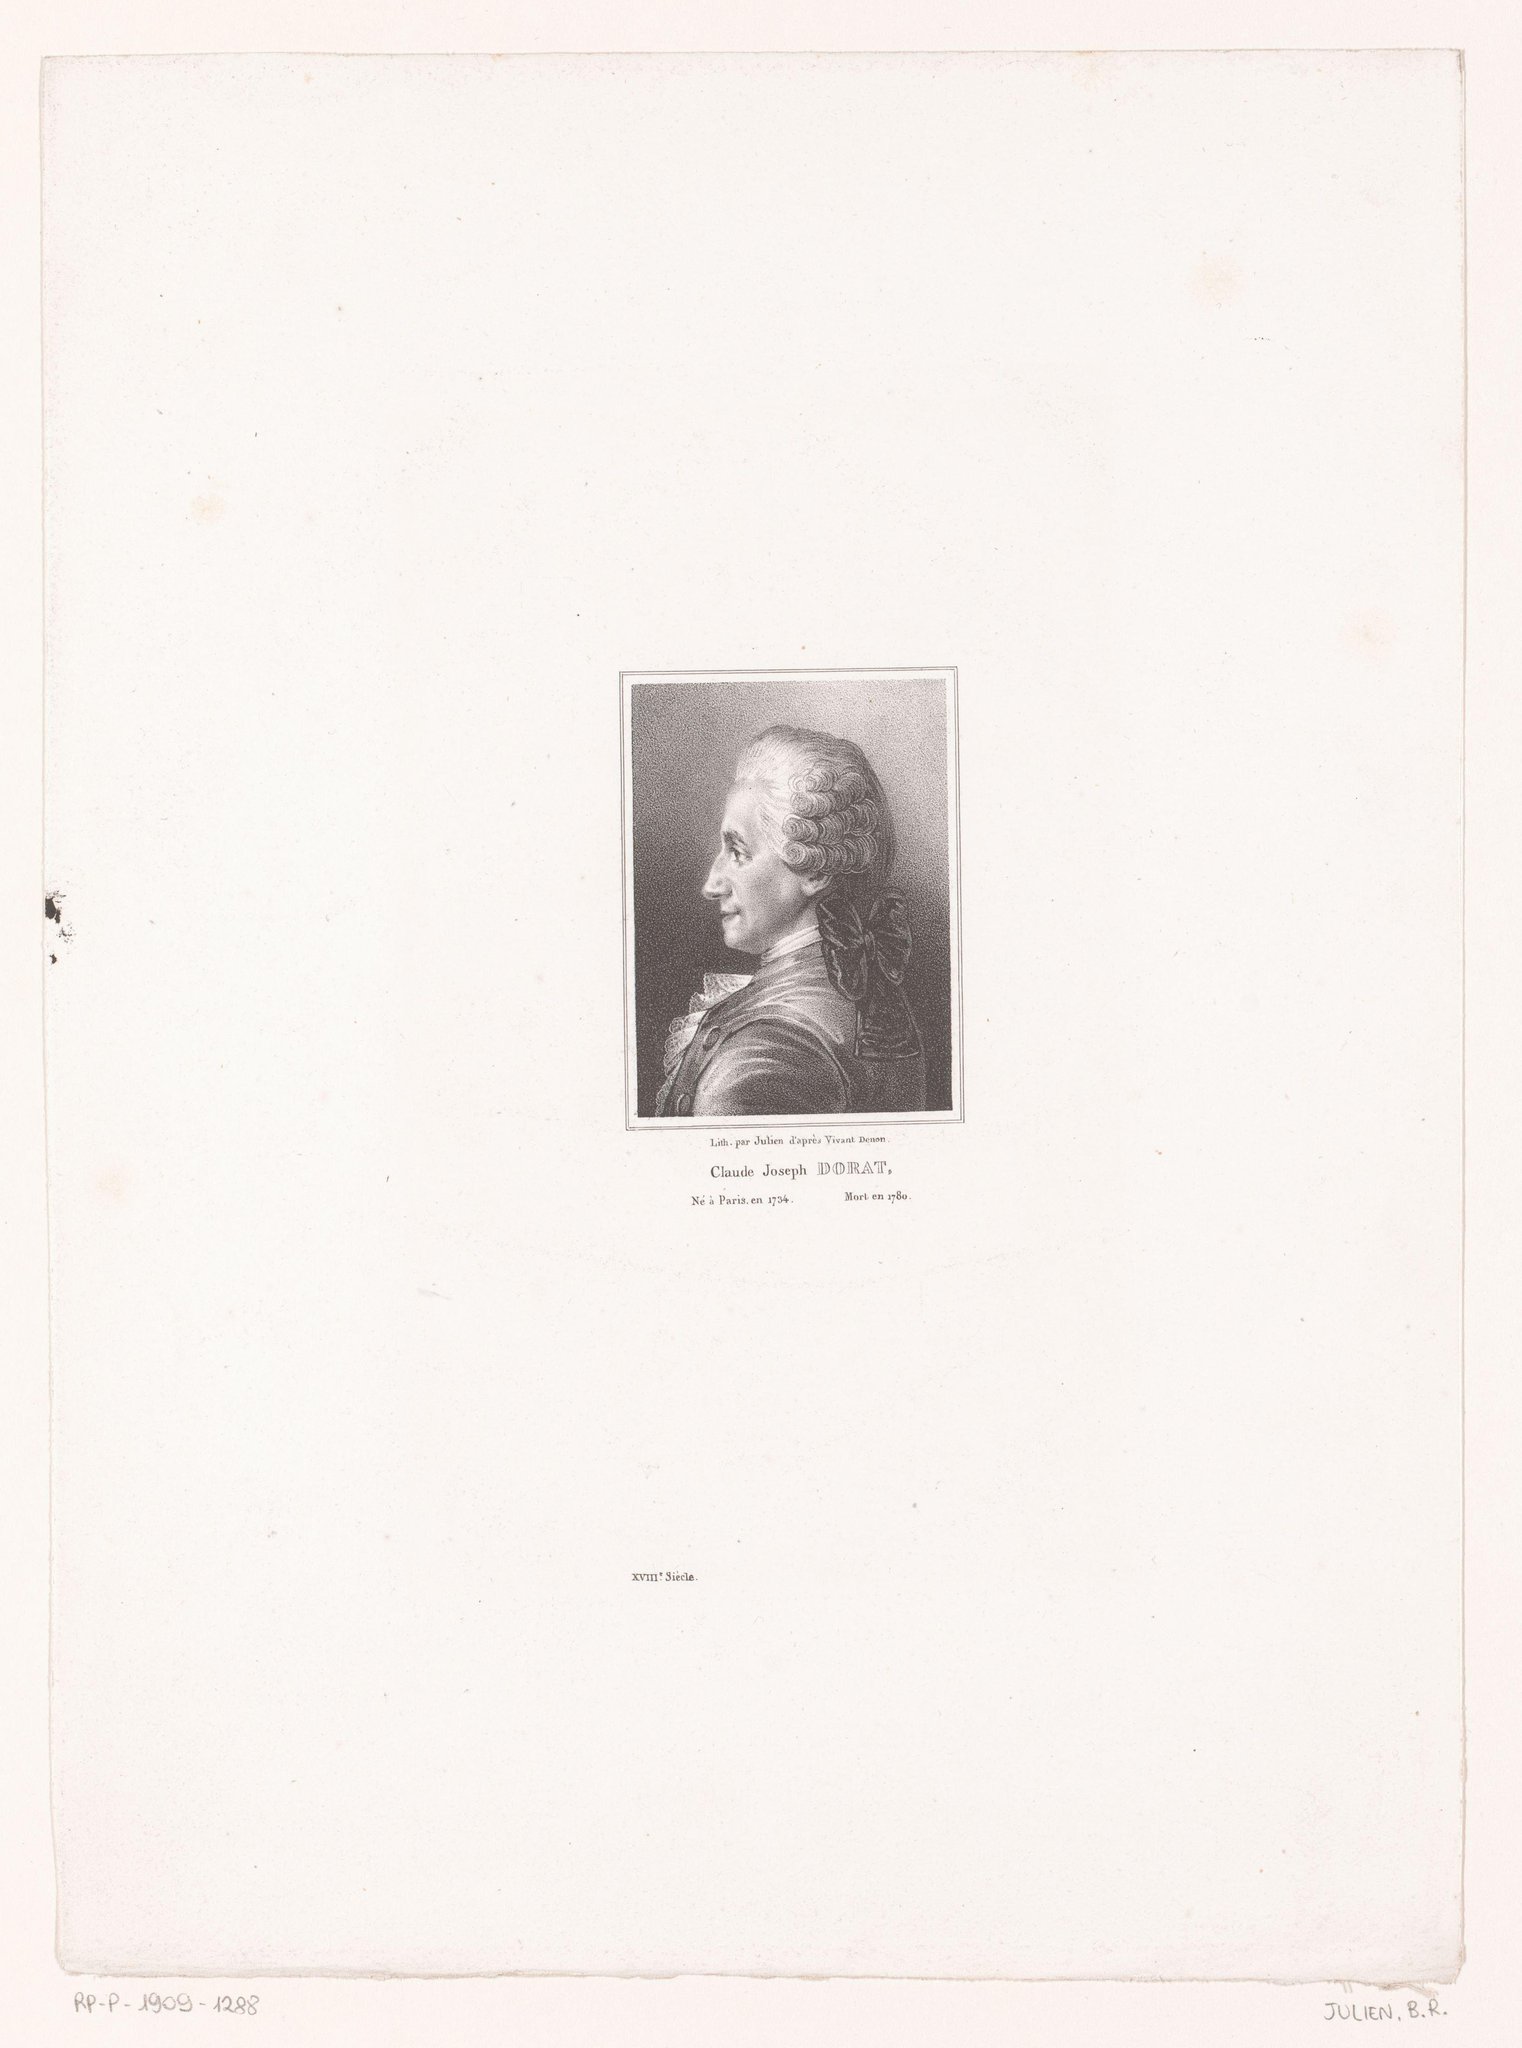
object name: print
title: Portret van Claude-Joseph Dorat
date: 1830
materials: paper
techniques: lithograph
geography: paris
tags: paris, claude-joseph dorat, historical persons, portrait of a writer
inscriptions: collector's mark: Lugt 2228a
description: Prent gebruikt voor: Illustrations du Cours de Littérature de la Harpe, ou collection de 400 portraits destinés à l'ornement de cet ouvrage. Parijs: Boblet, 1830.